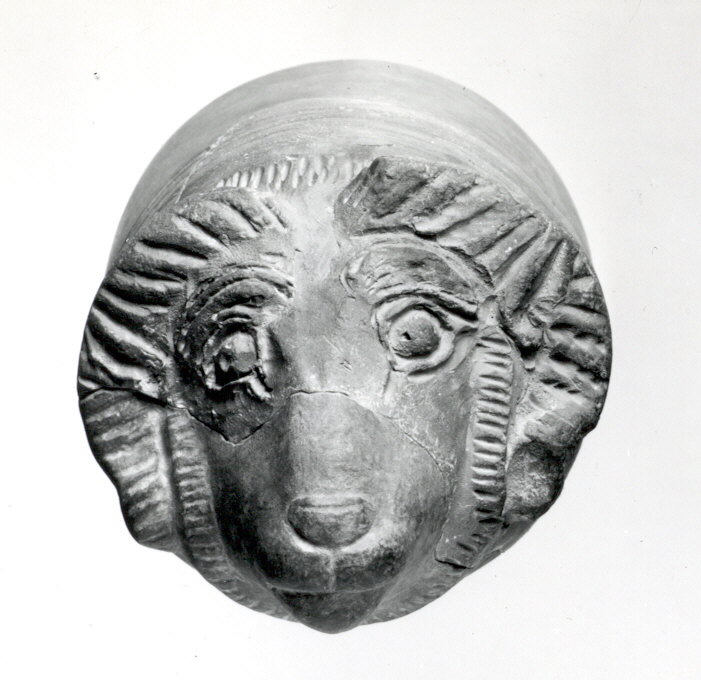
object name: vessel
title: Drinking vessel in the form of a ram's head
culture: assyrian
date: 700-601 BCE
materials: ceramic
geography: mesopotamia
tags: rams